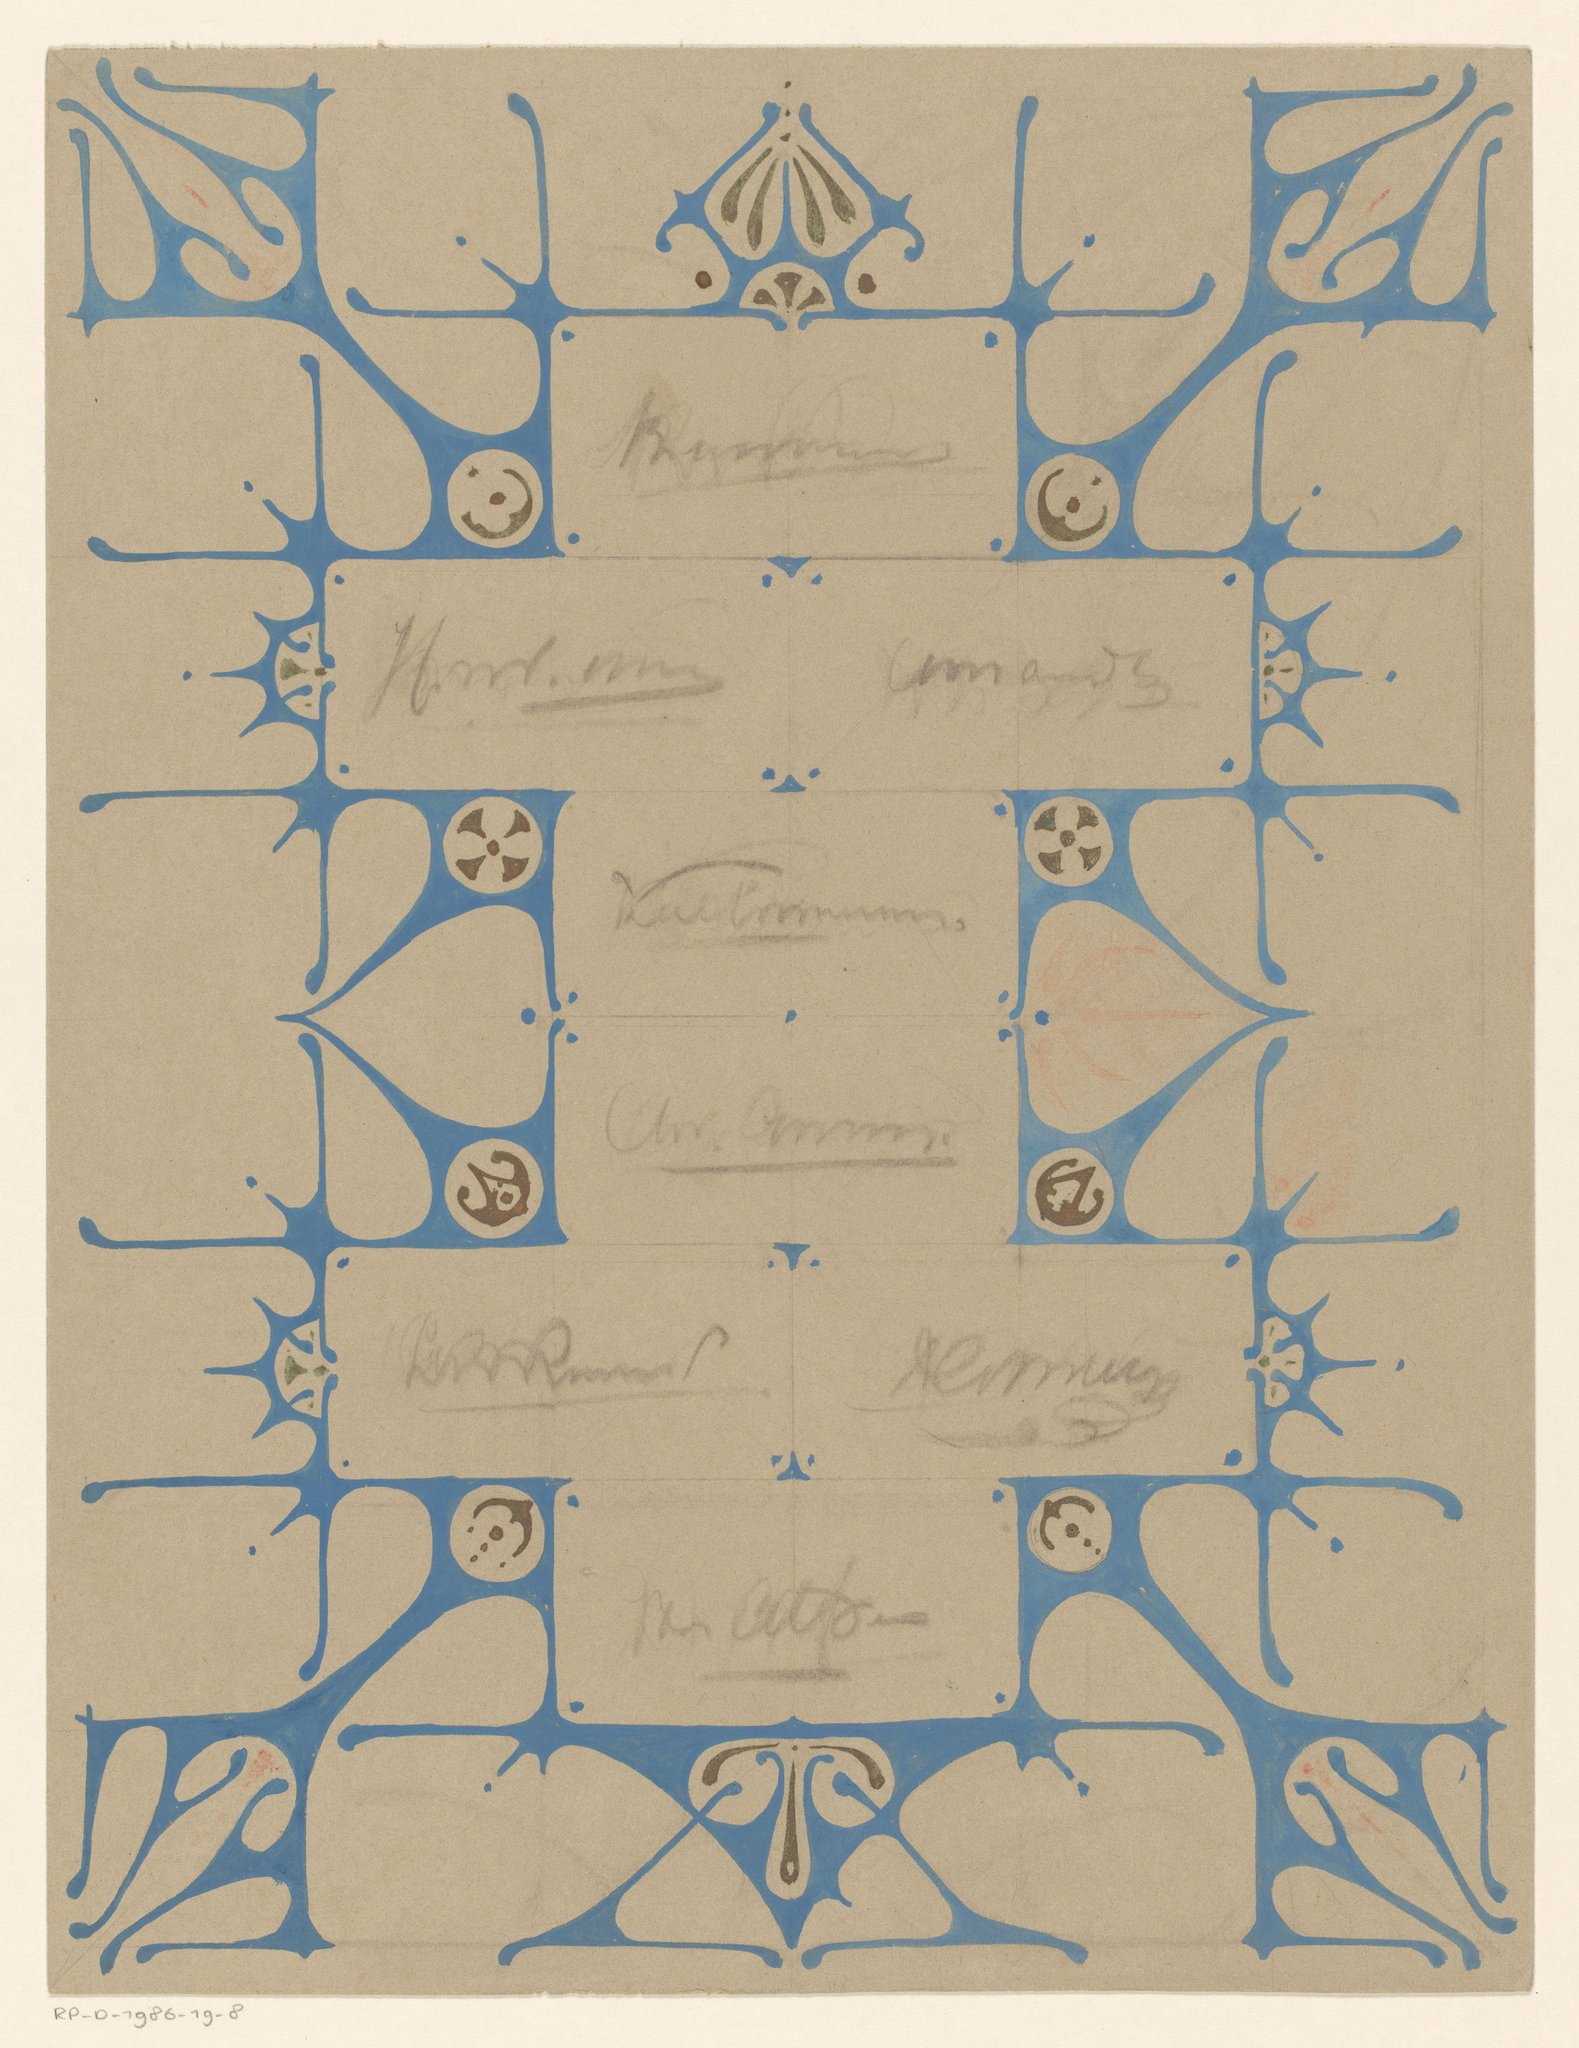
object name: design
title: Blad met acht handtekeningen in een geornamenteerd kader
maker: reinier willem petrus de vries (1874-1953)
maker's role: draughtsman, print maker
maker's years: 1874-1953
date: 1901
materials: paint, paper, pencil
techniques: brush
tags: publisher, albertus willem sijthoff, ornaments ~ art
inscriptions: collector's mark: ‘R:MVS.’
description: Ontwerp voor een album voor A.W. Sijthoff ter gelegenheid van zijn vijftigjarige uitgeversloopbaan.